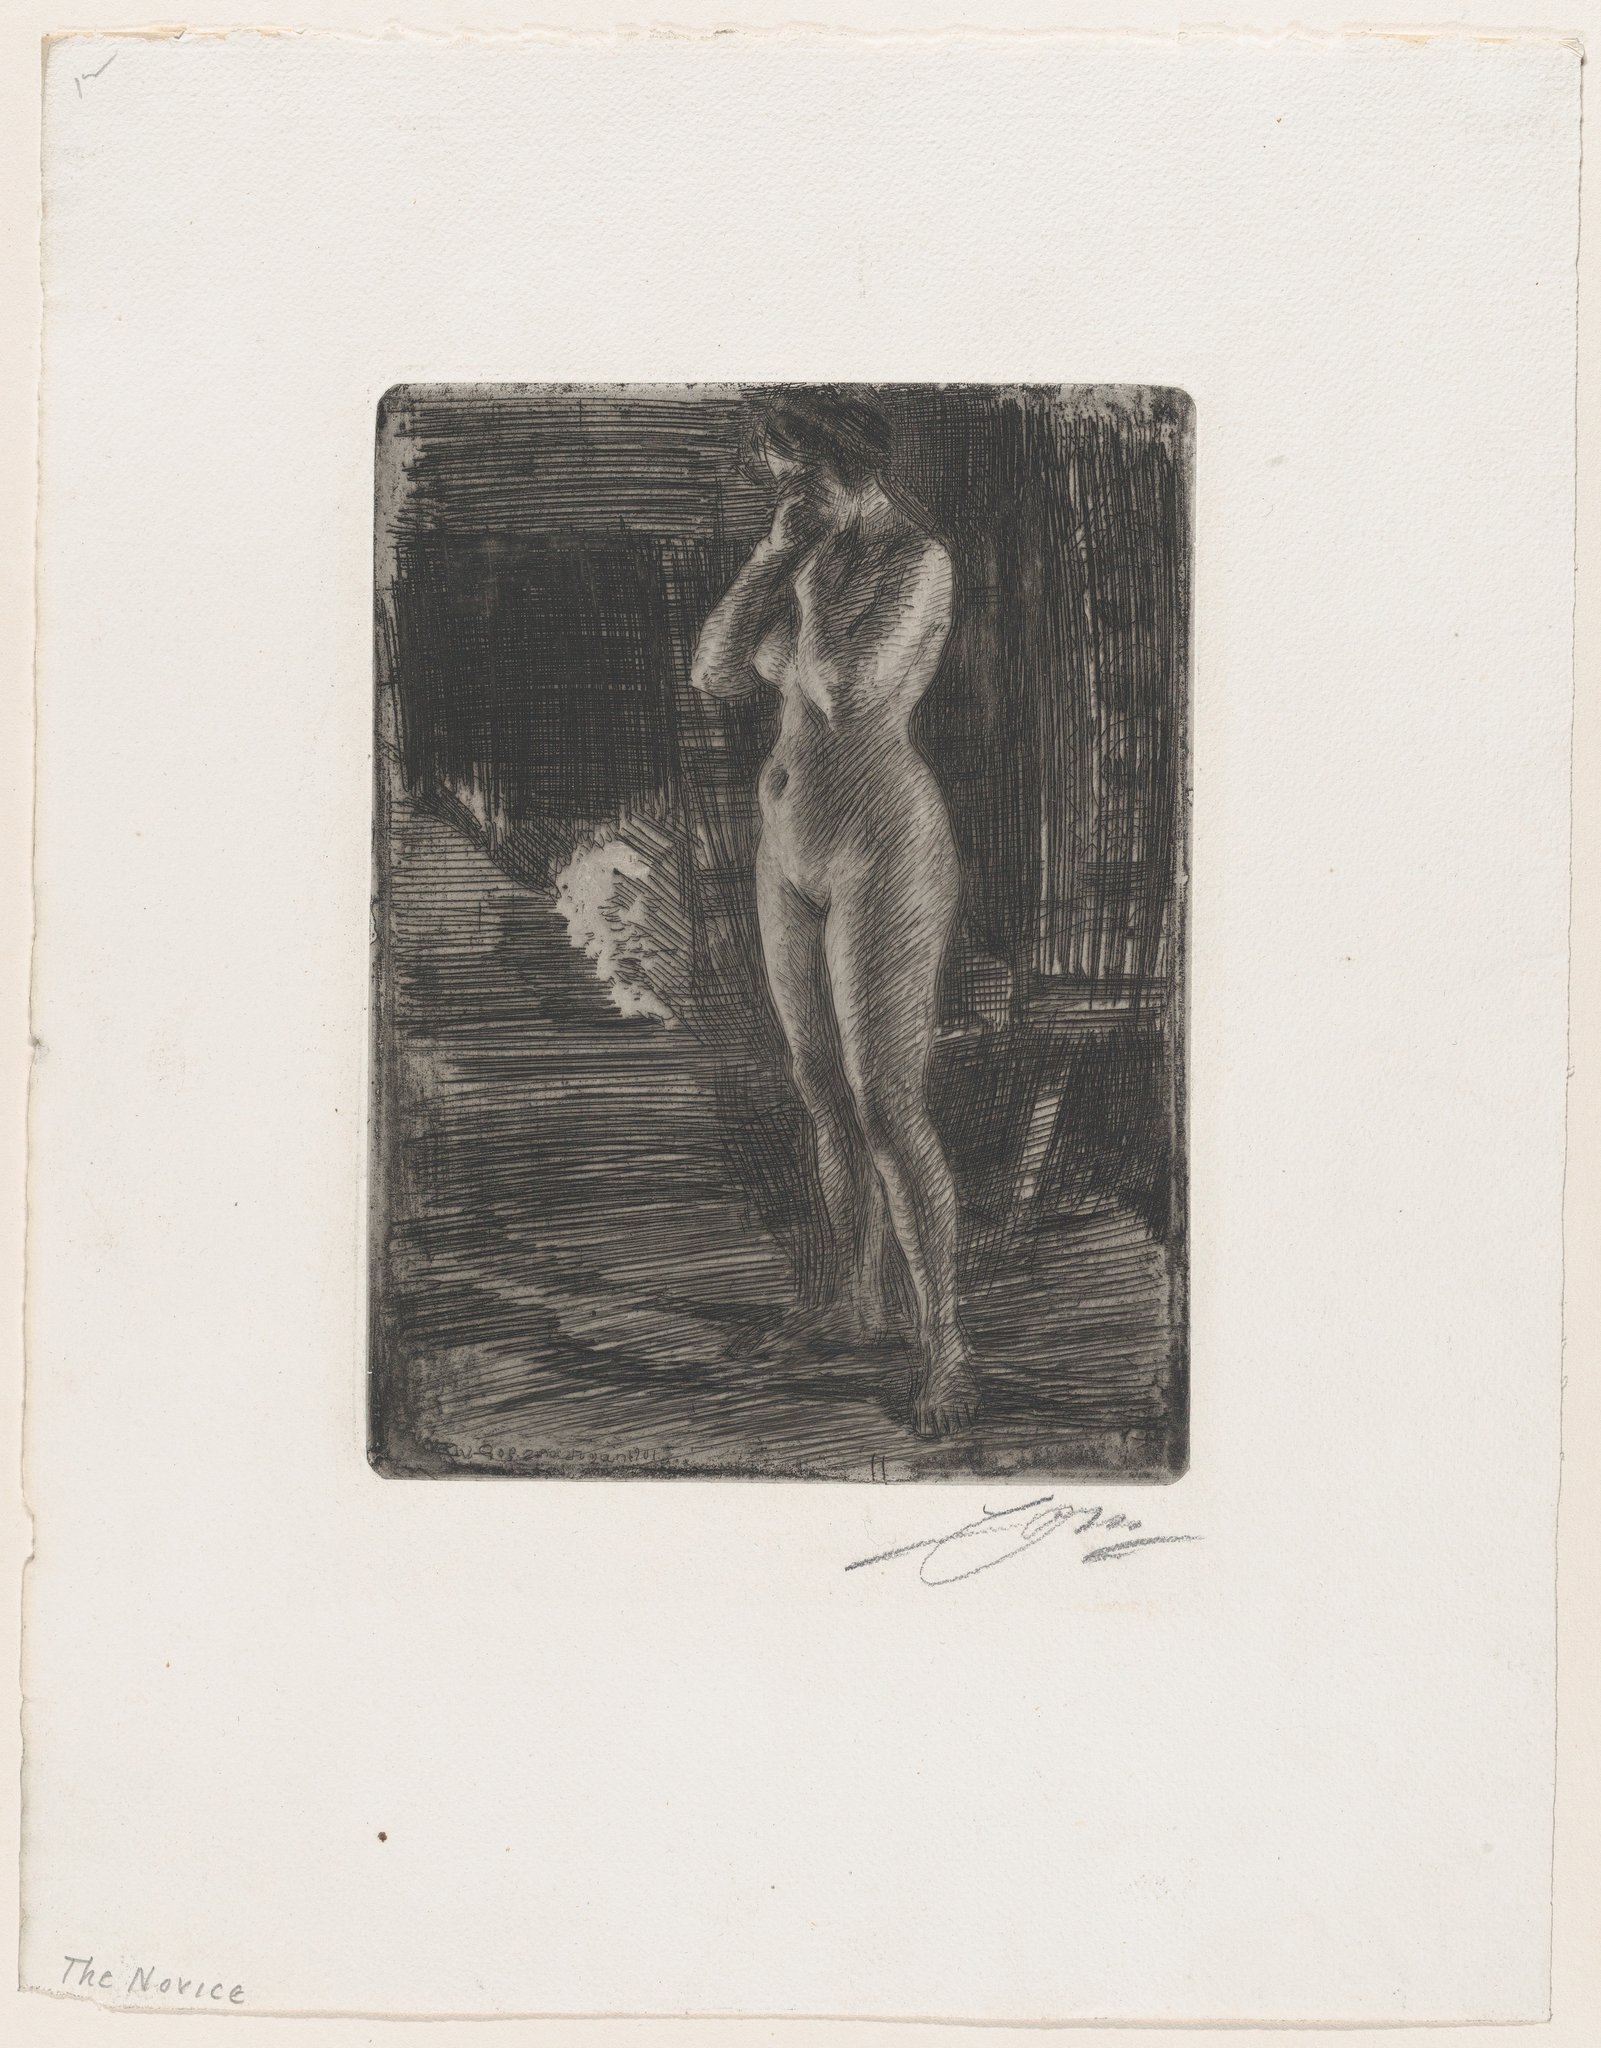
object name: print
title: The First Pose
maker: anders zorn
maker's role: artist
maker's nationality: swedish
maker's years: 1860-1920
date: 1906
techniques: etching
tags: female nudes